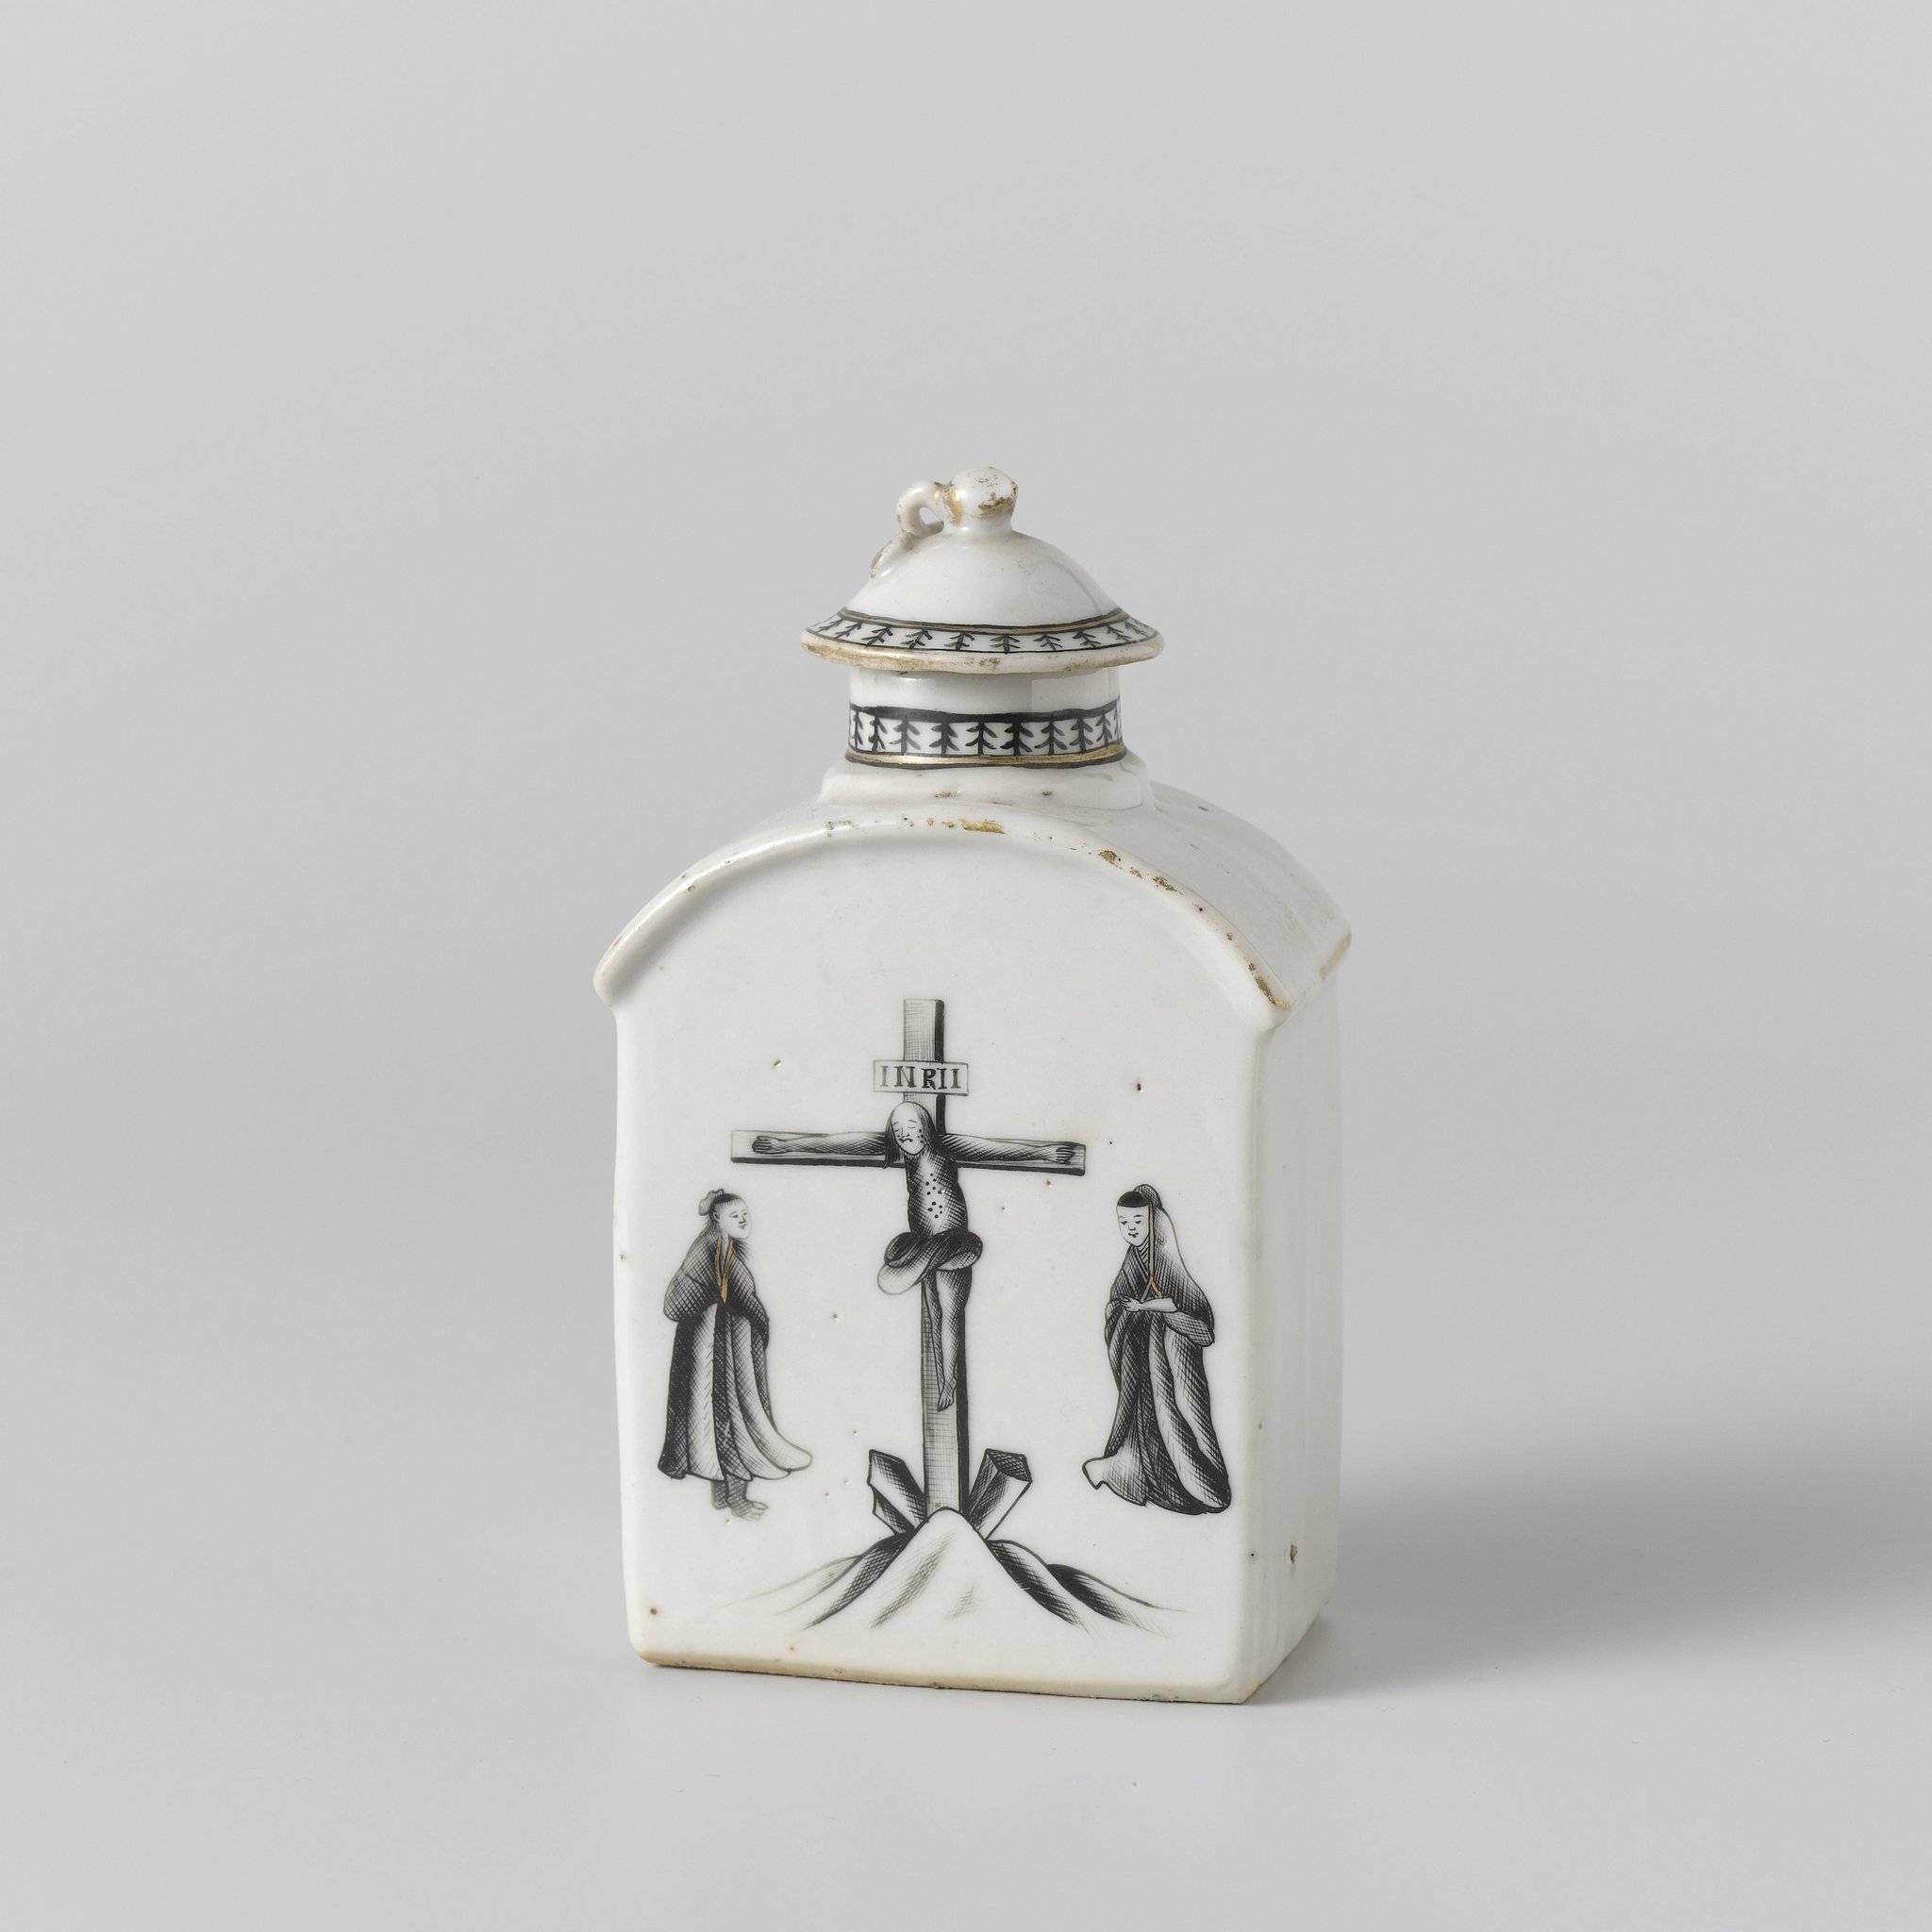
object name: tea caddy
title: Rectangular tea caddy with a crucifixion scene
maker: Anonymous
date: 1780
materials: glaze, gold, paint, porcelain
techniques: firing, forming, gilding, turning, vitrification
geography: china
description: Rechthoekige theebus van porselein met iets verdikte, ronde schouder en deksel, beschilderd op het glazuur in zwart en goud. Op de buitenzijde tweemaal een voorstelling van de Kruisiging met de twee Maria's; de nek en de dekselrand met een band met een decoratief patroon. Dekselknop in de vorm van een perzik. Onderzijde ongeglazuurd. Onderdeel van een theeservies. Europese voorstelling in encre de Chine.